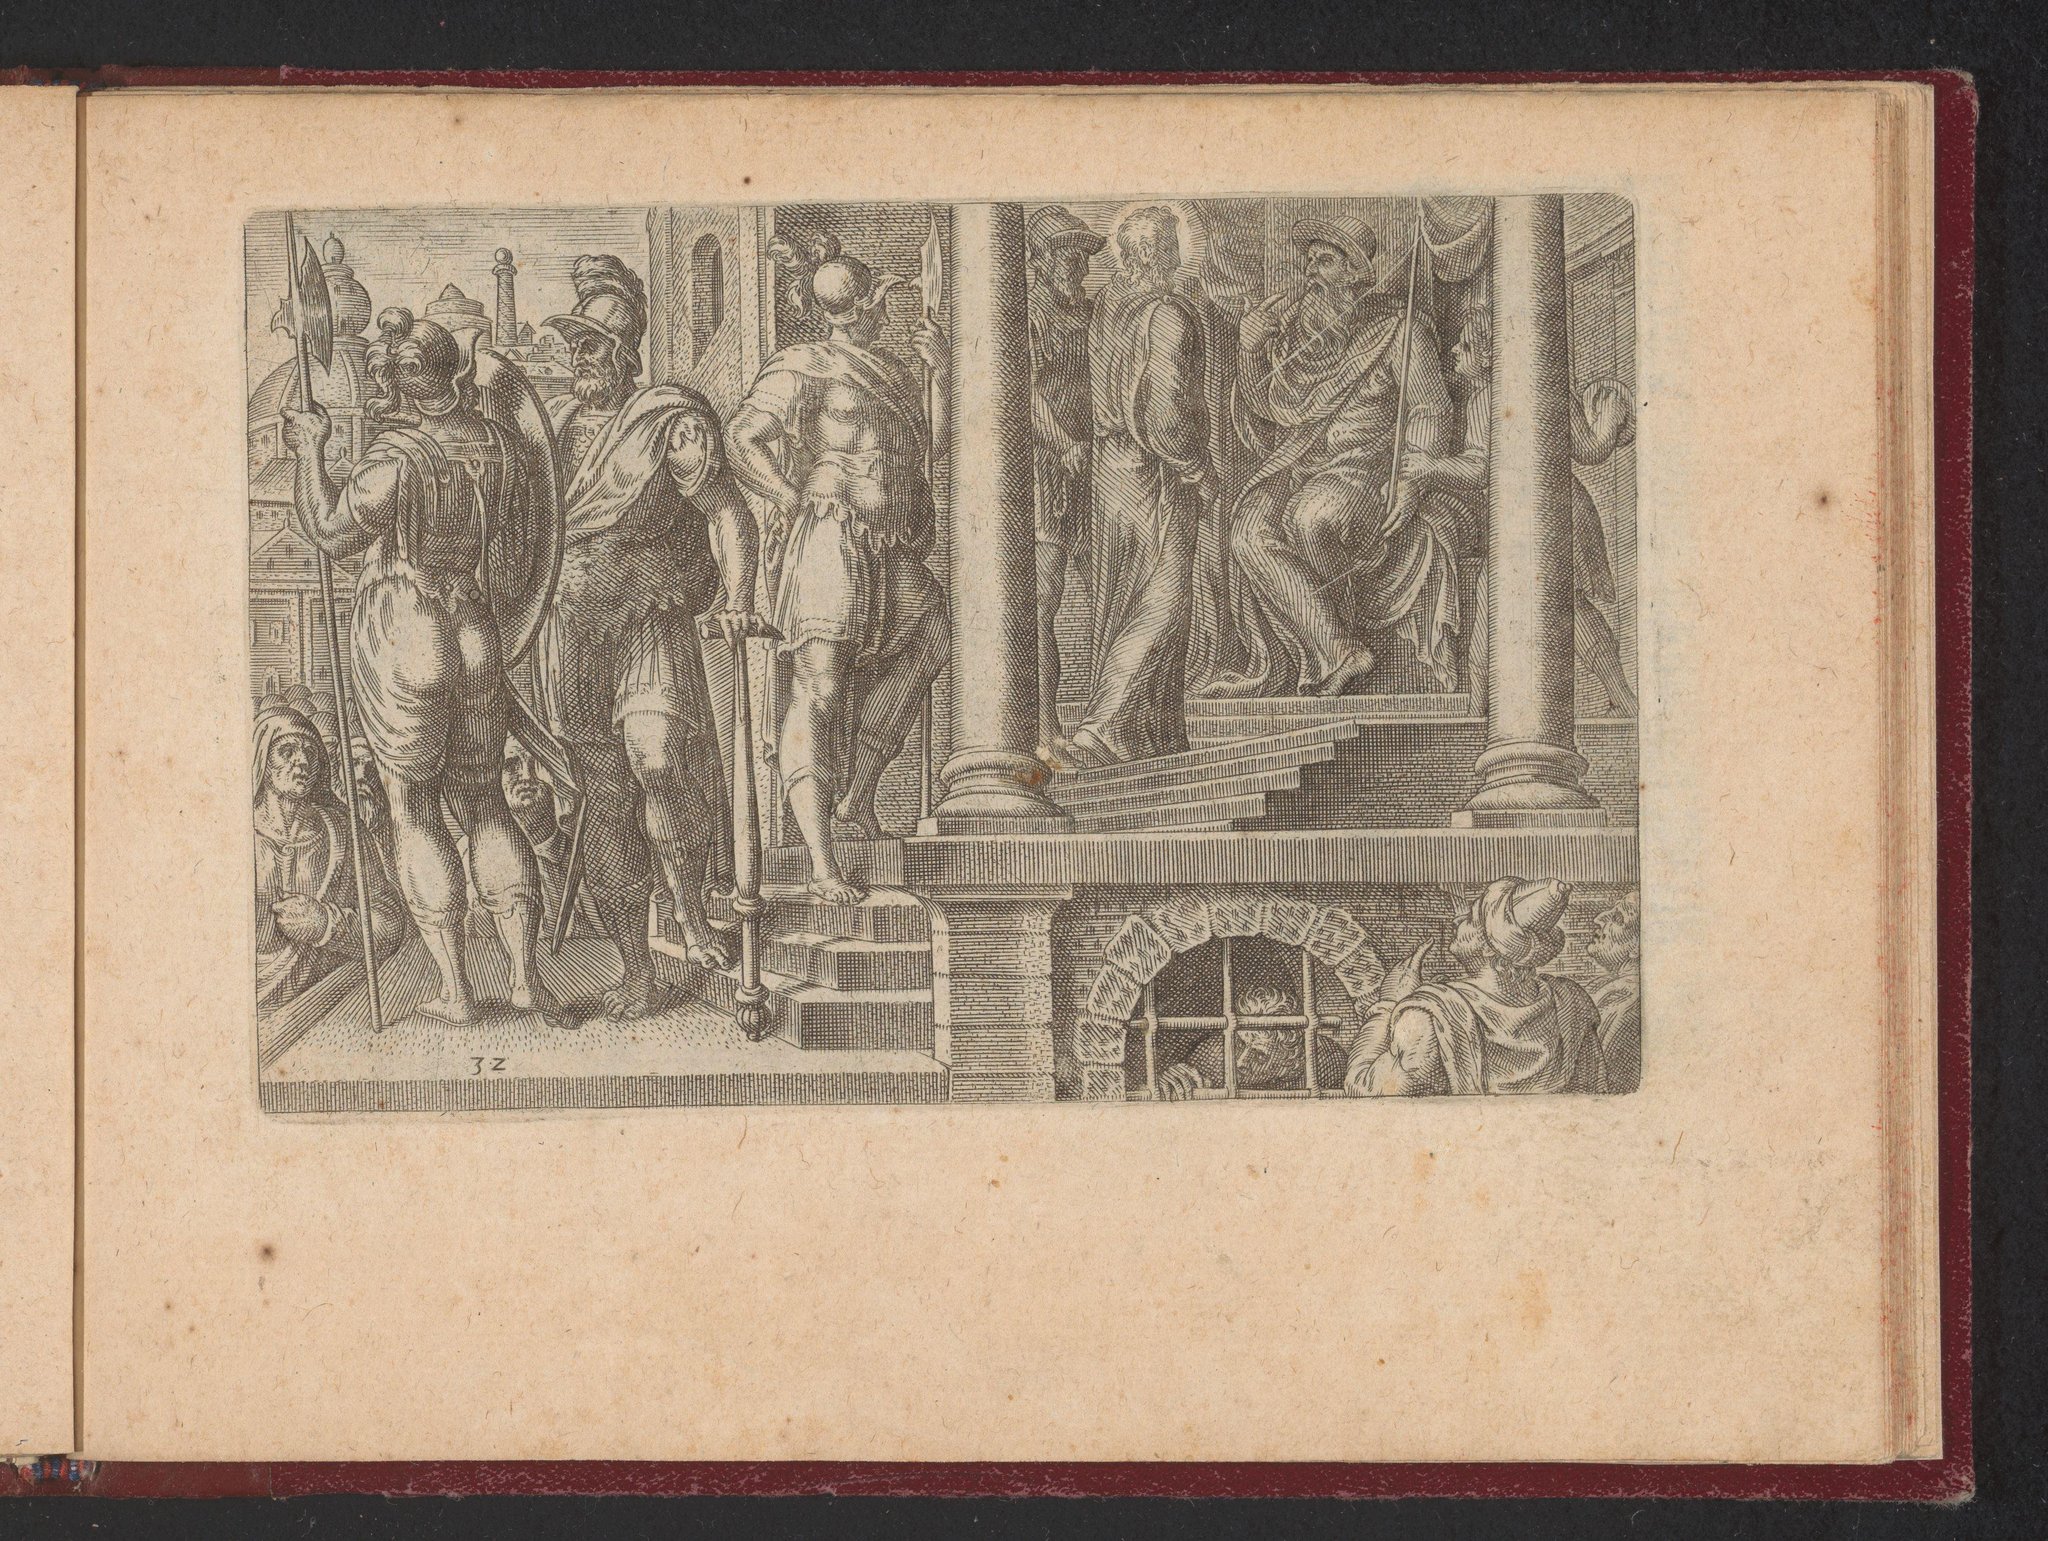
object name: print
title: Christi Iesu vitae admirabiliumque actionum speculum a Philippo Gallaeo apparatum Bened. Ariae Montani singuloribus distichis instructum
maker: philips galle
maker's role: print maker, publisher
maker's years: 1537-1612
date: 1573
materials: paper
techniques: engraving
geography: antwerp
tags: choice between christ and barabbas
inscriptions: watermark: ‘gotische letter P’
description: Onderdeel van een album met een titelprent en een serie van 50 prenten betreffende het leven en de passie van Christus.